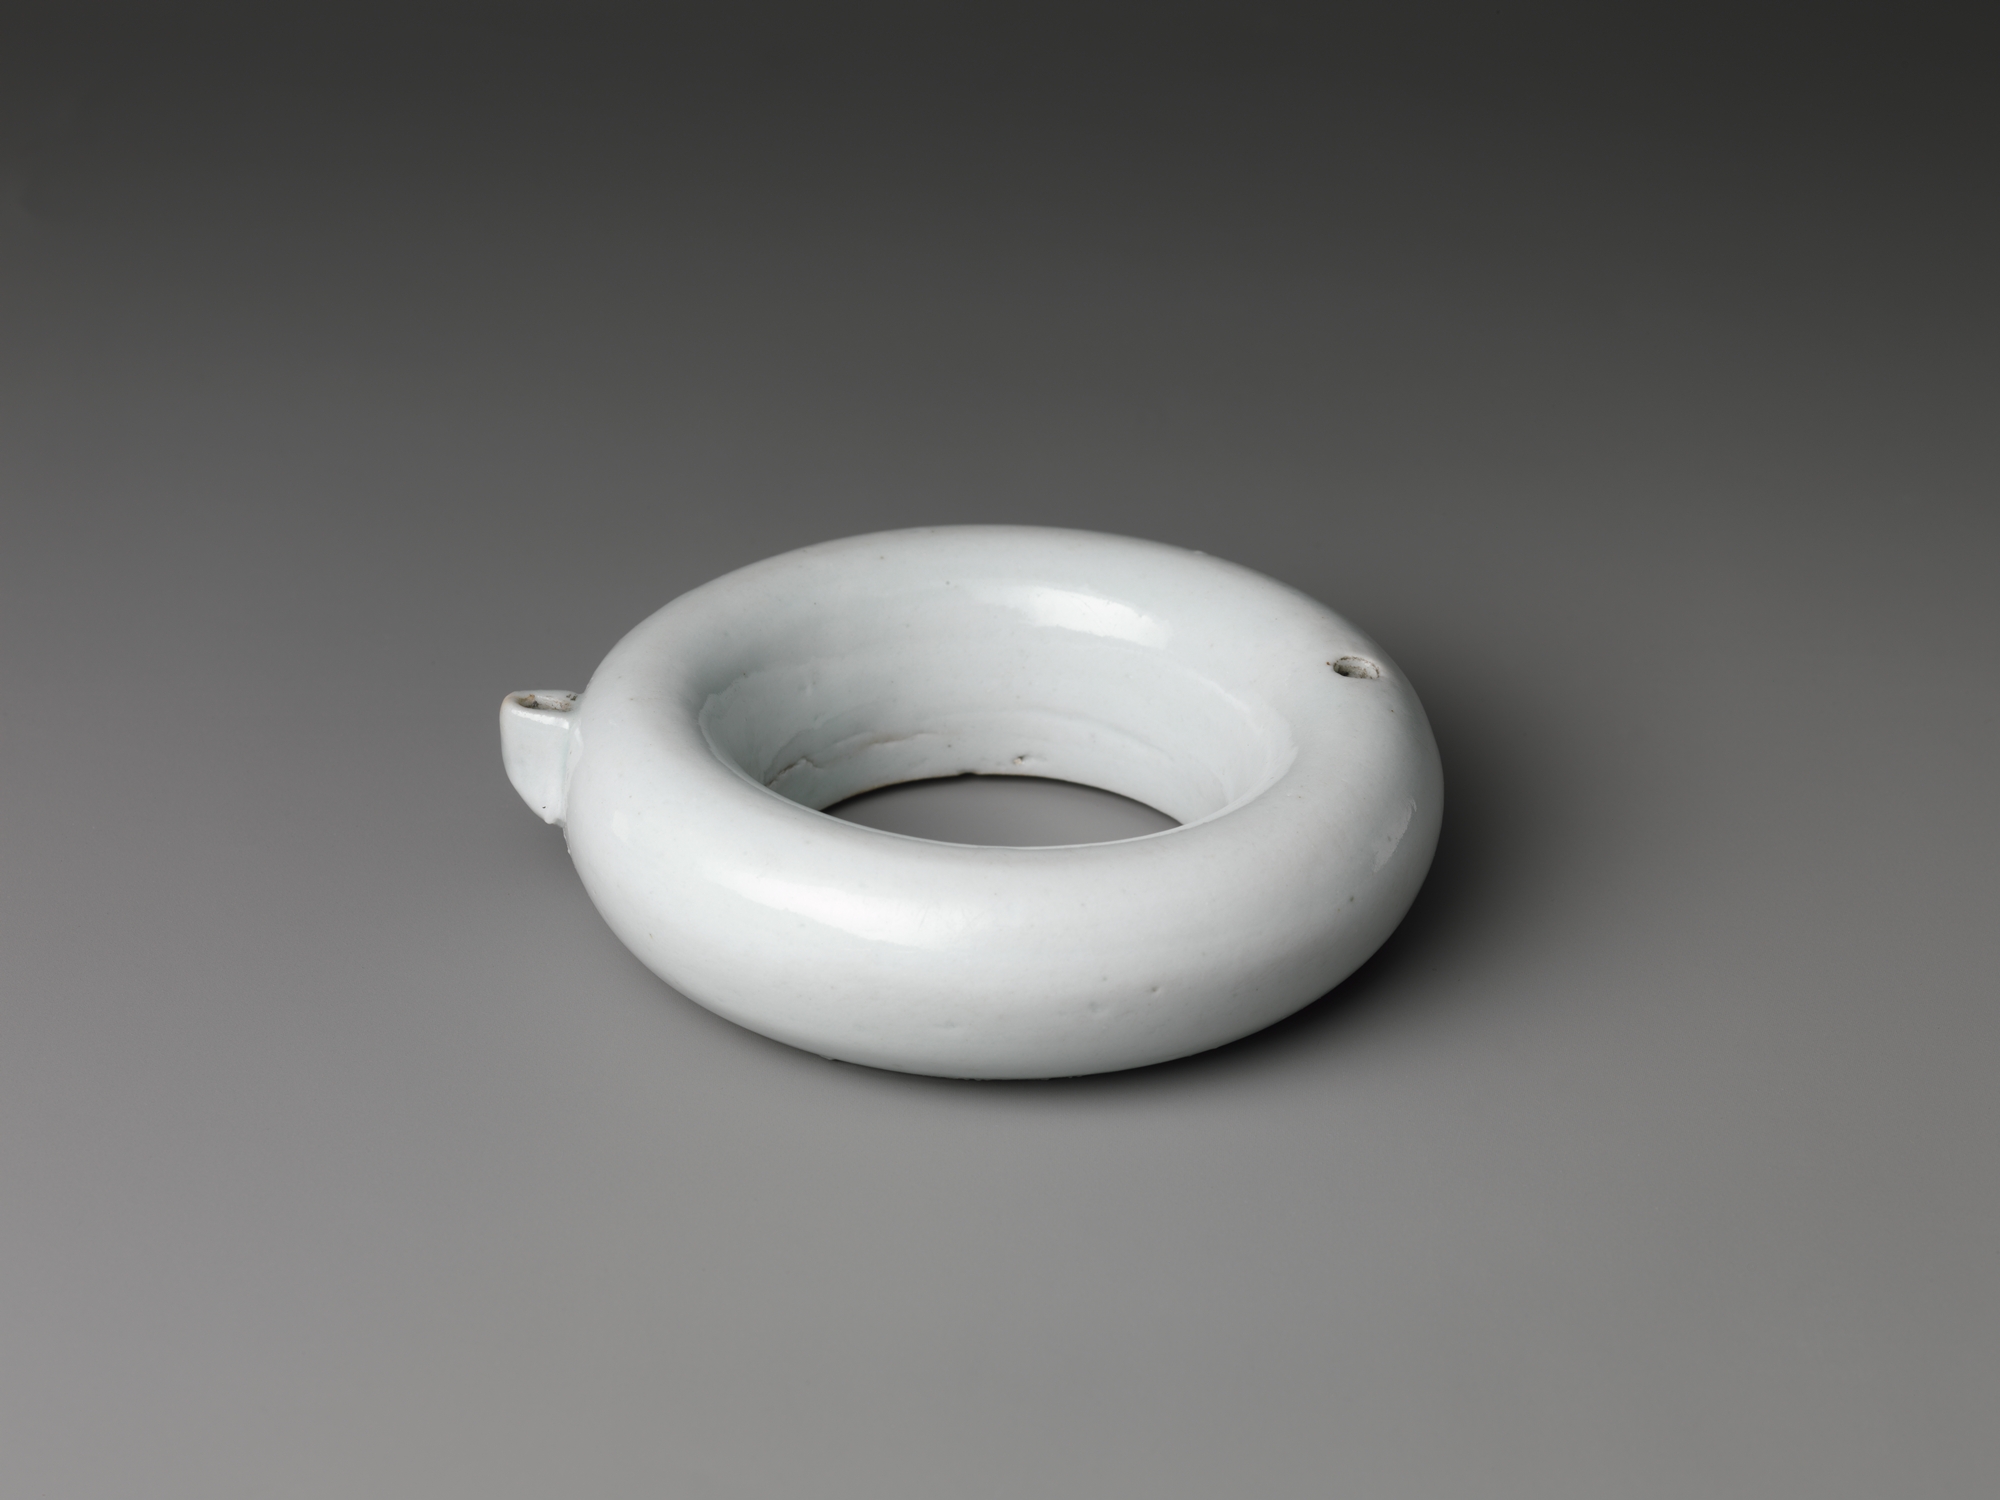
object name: water dropper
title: Ring-shaped water dropper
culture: korean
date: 1801-1900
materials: porcelain